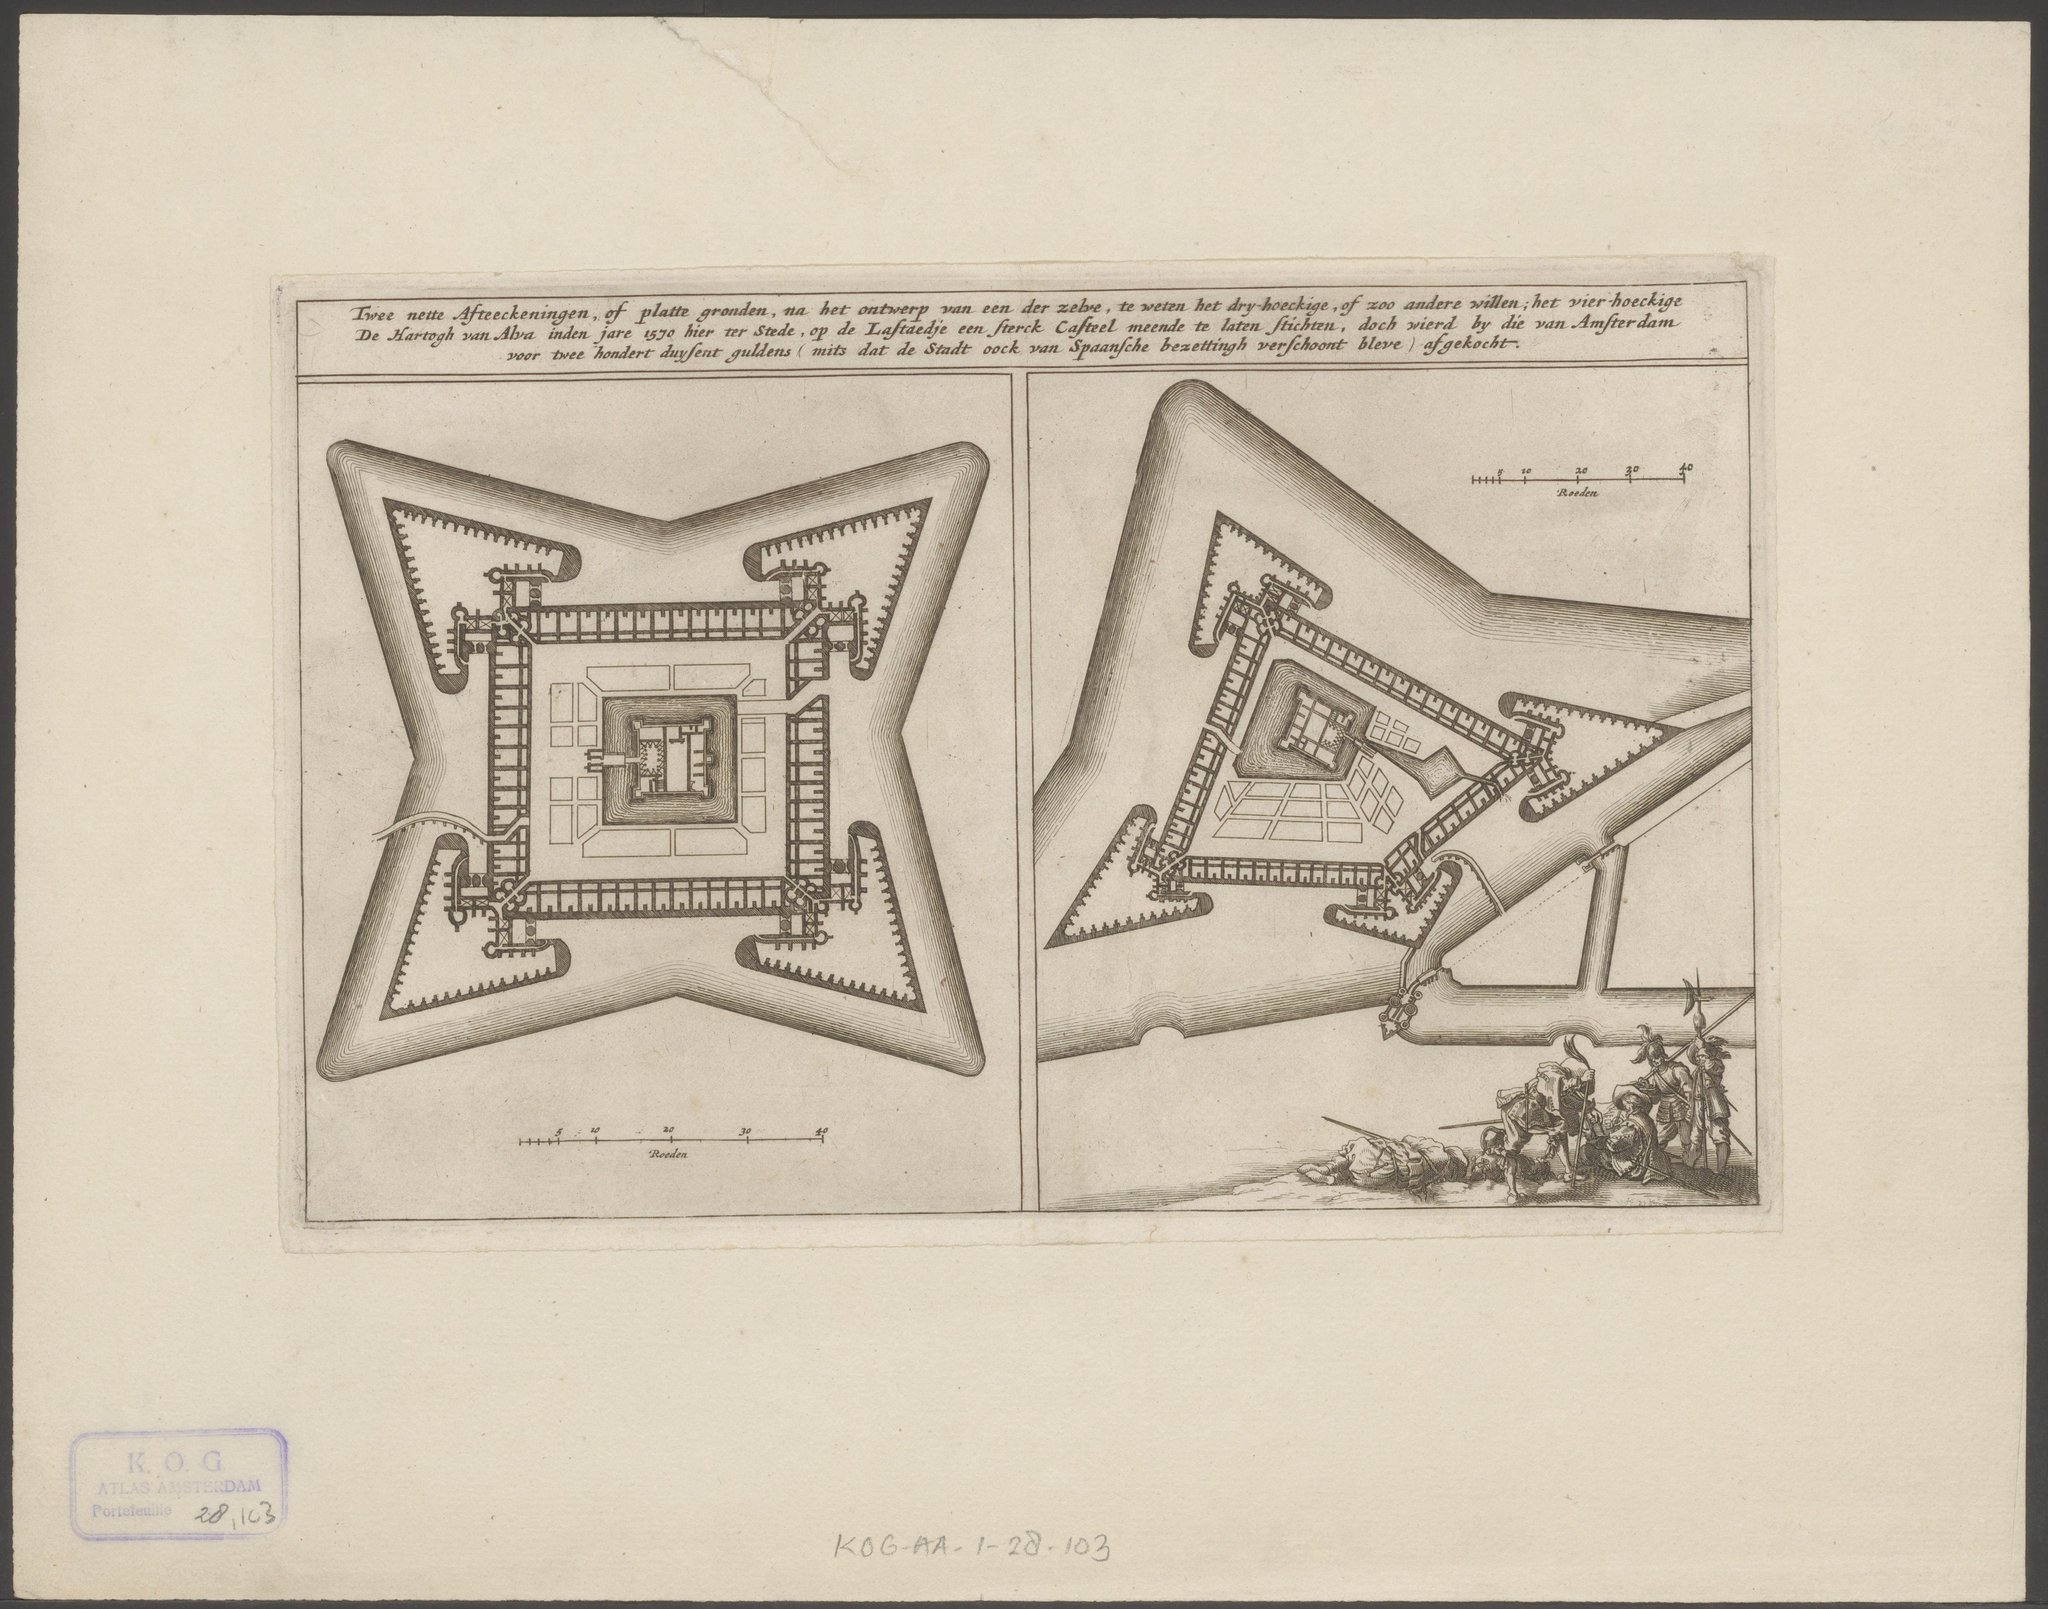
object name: area plan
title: Twee plattegronden van een onuitgevoerde vesting te Amsterdam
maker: Anonymous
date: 1663-1664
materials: paper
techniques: engraving, etching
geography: northern netherlands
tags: fernando álvarez de toledo (3rd duke of alba), draughtsman at work, fortifications, military engineering, plan ~ architecture, amsterdam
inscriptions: collector's mark: Lugt 1641b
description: Twee plattegronden voor de vesting die de hertog van Alva te Amsterdam op de Lastage wilde bouwen, maar door de stad werd afgekocht. Rechtsonder een groepje soldaten rond een militaire tekenaar. Onderwerpsrubriek binnen de Atlas Amsterdam: Vestingwerken: Bolwerken - Rondeel - Wachttorens - Blokhuizen - Kazematten - Ontwerpen Kostuum Alva.